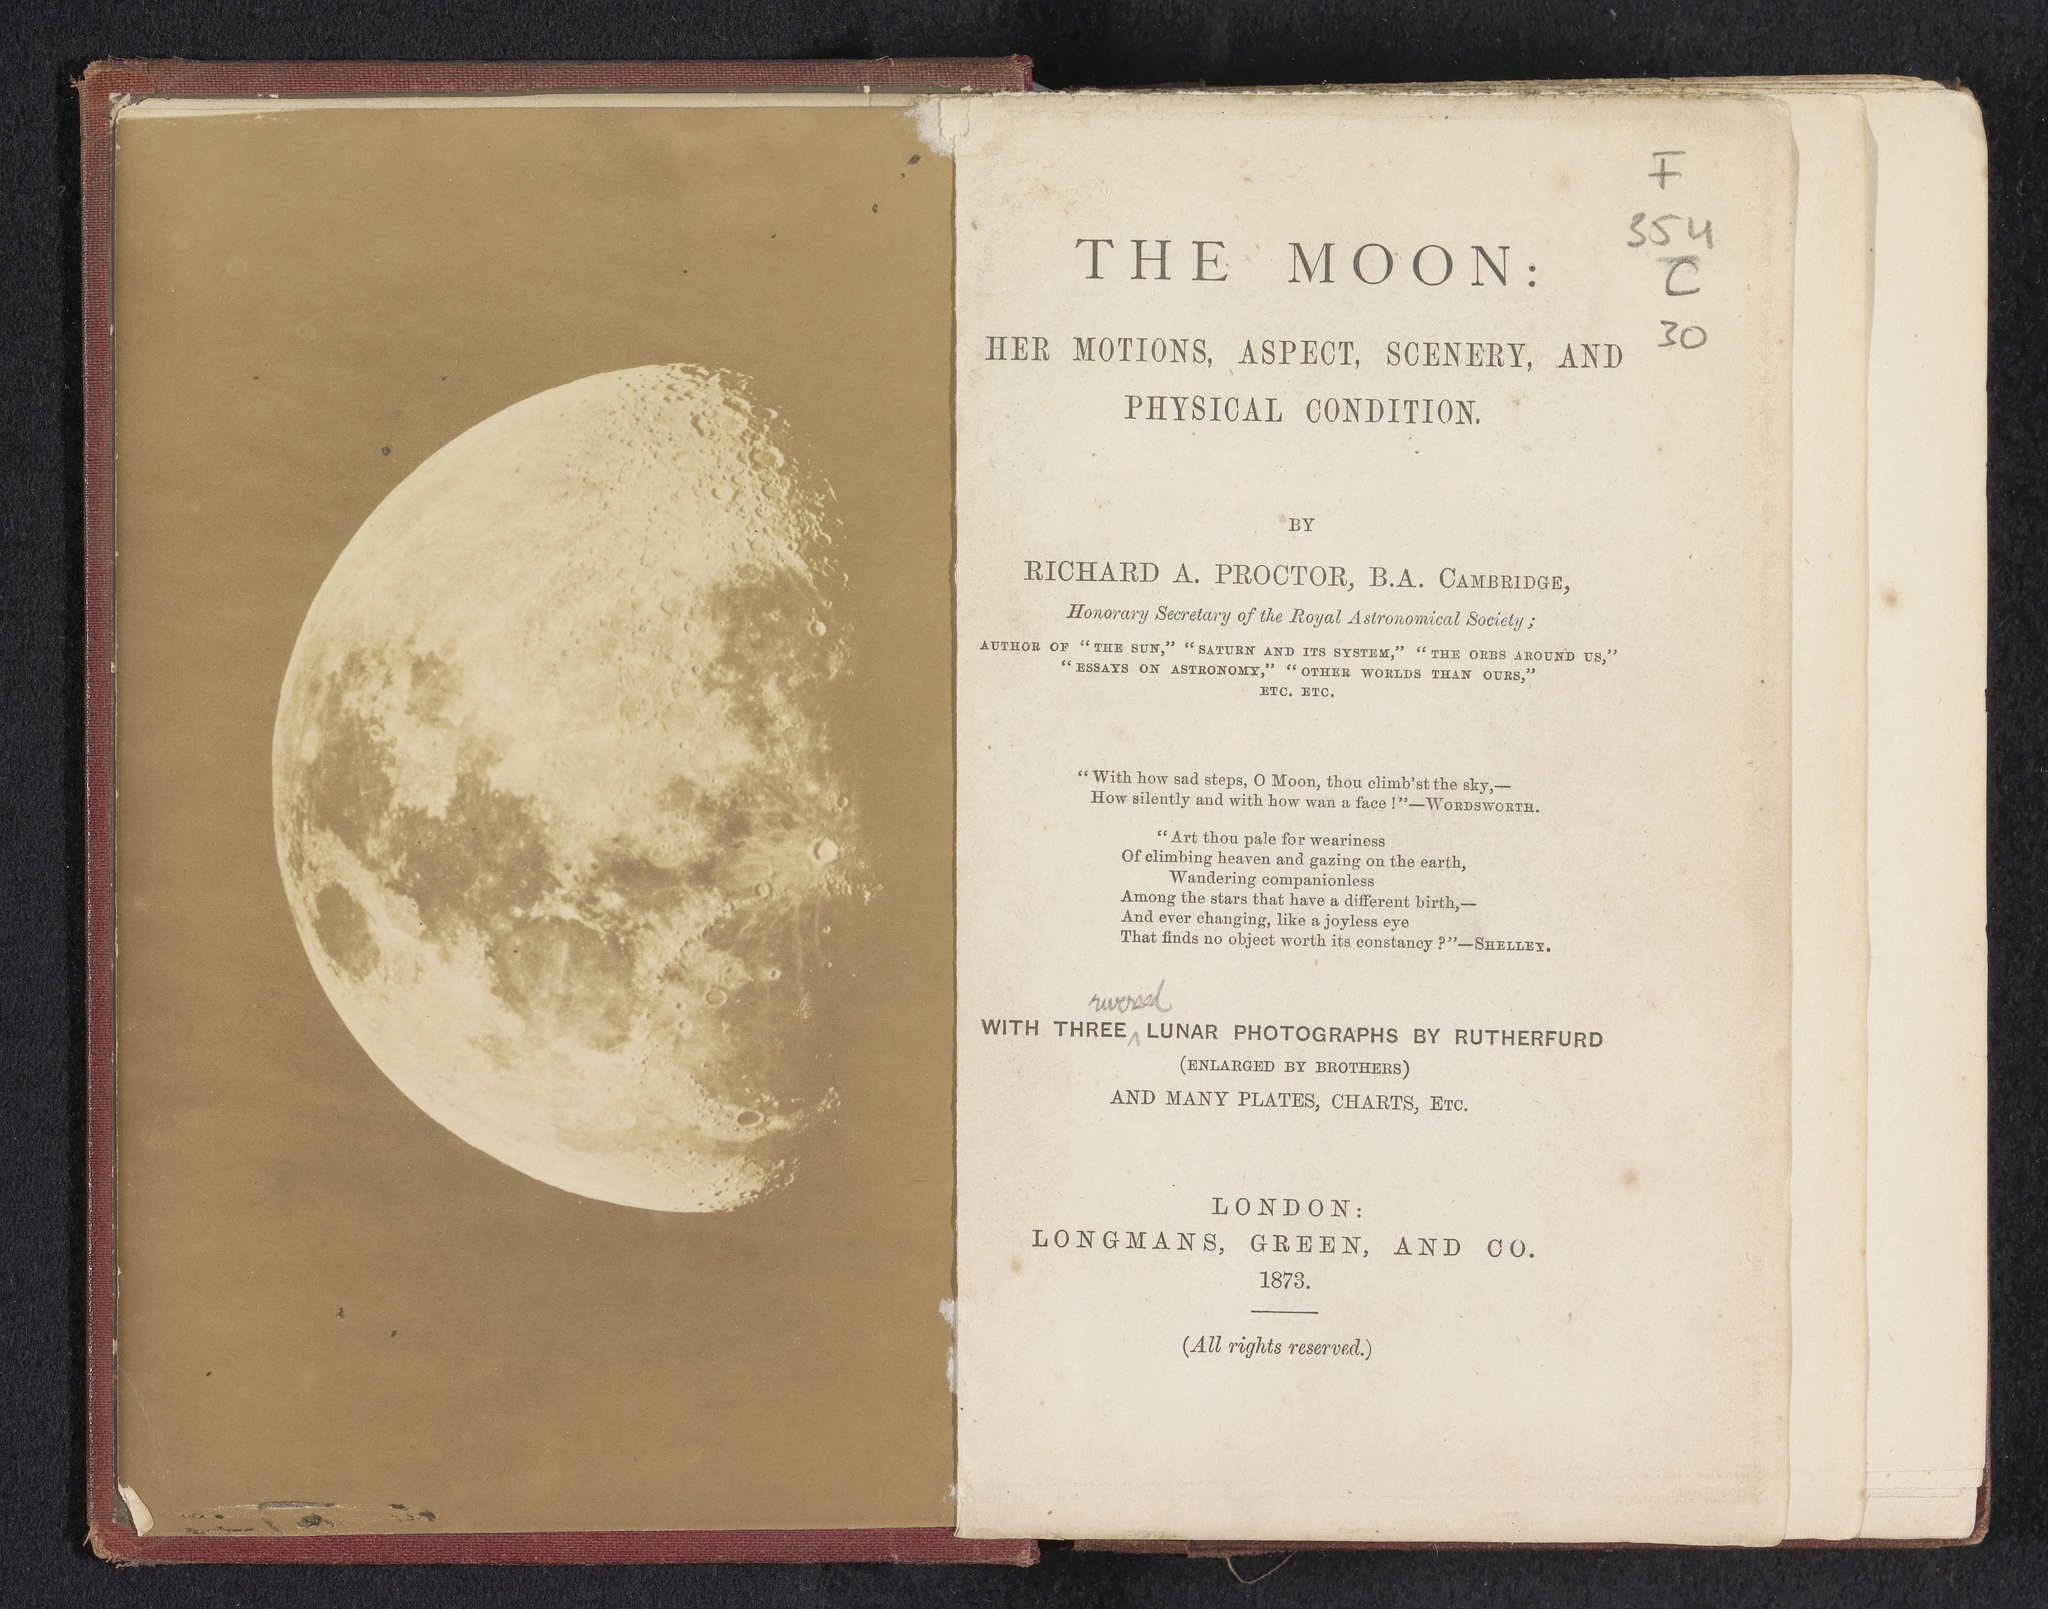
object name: page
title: Maan in het eerste kwartier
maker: lewis morris rutherfurd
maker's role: advocaat, astronoom, fotograaf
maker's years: 1816-1892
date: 1863-1873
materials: photographic support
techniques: albumen print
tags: waning moon, i.e. facing this way (, moon